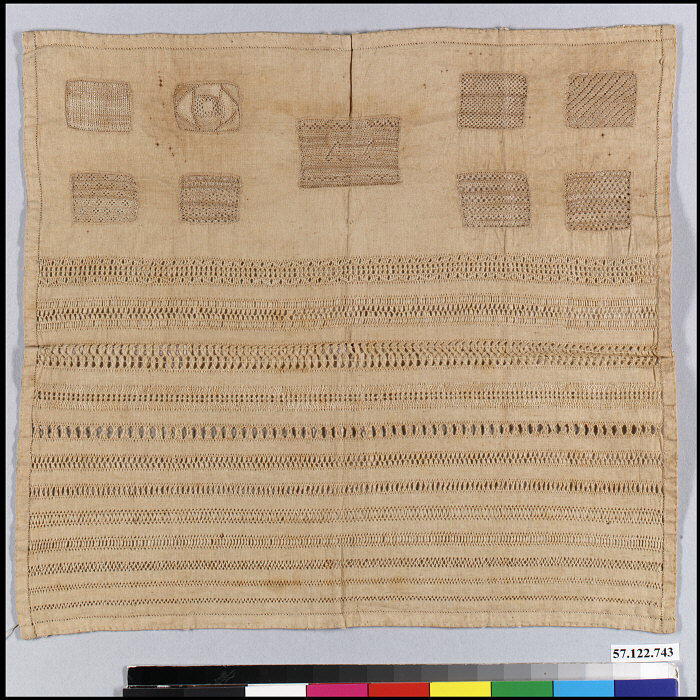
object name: sampler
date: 1701-1800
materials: linen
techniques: embroidery, lace